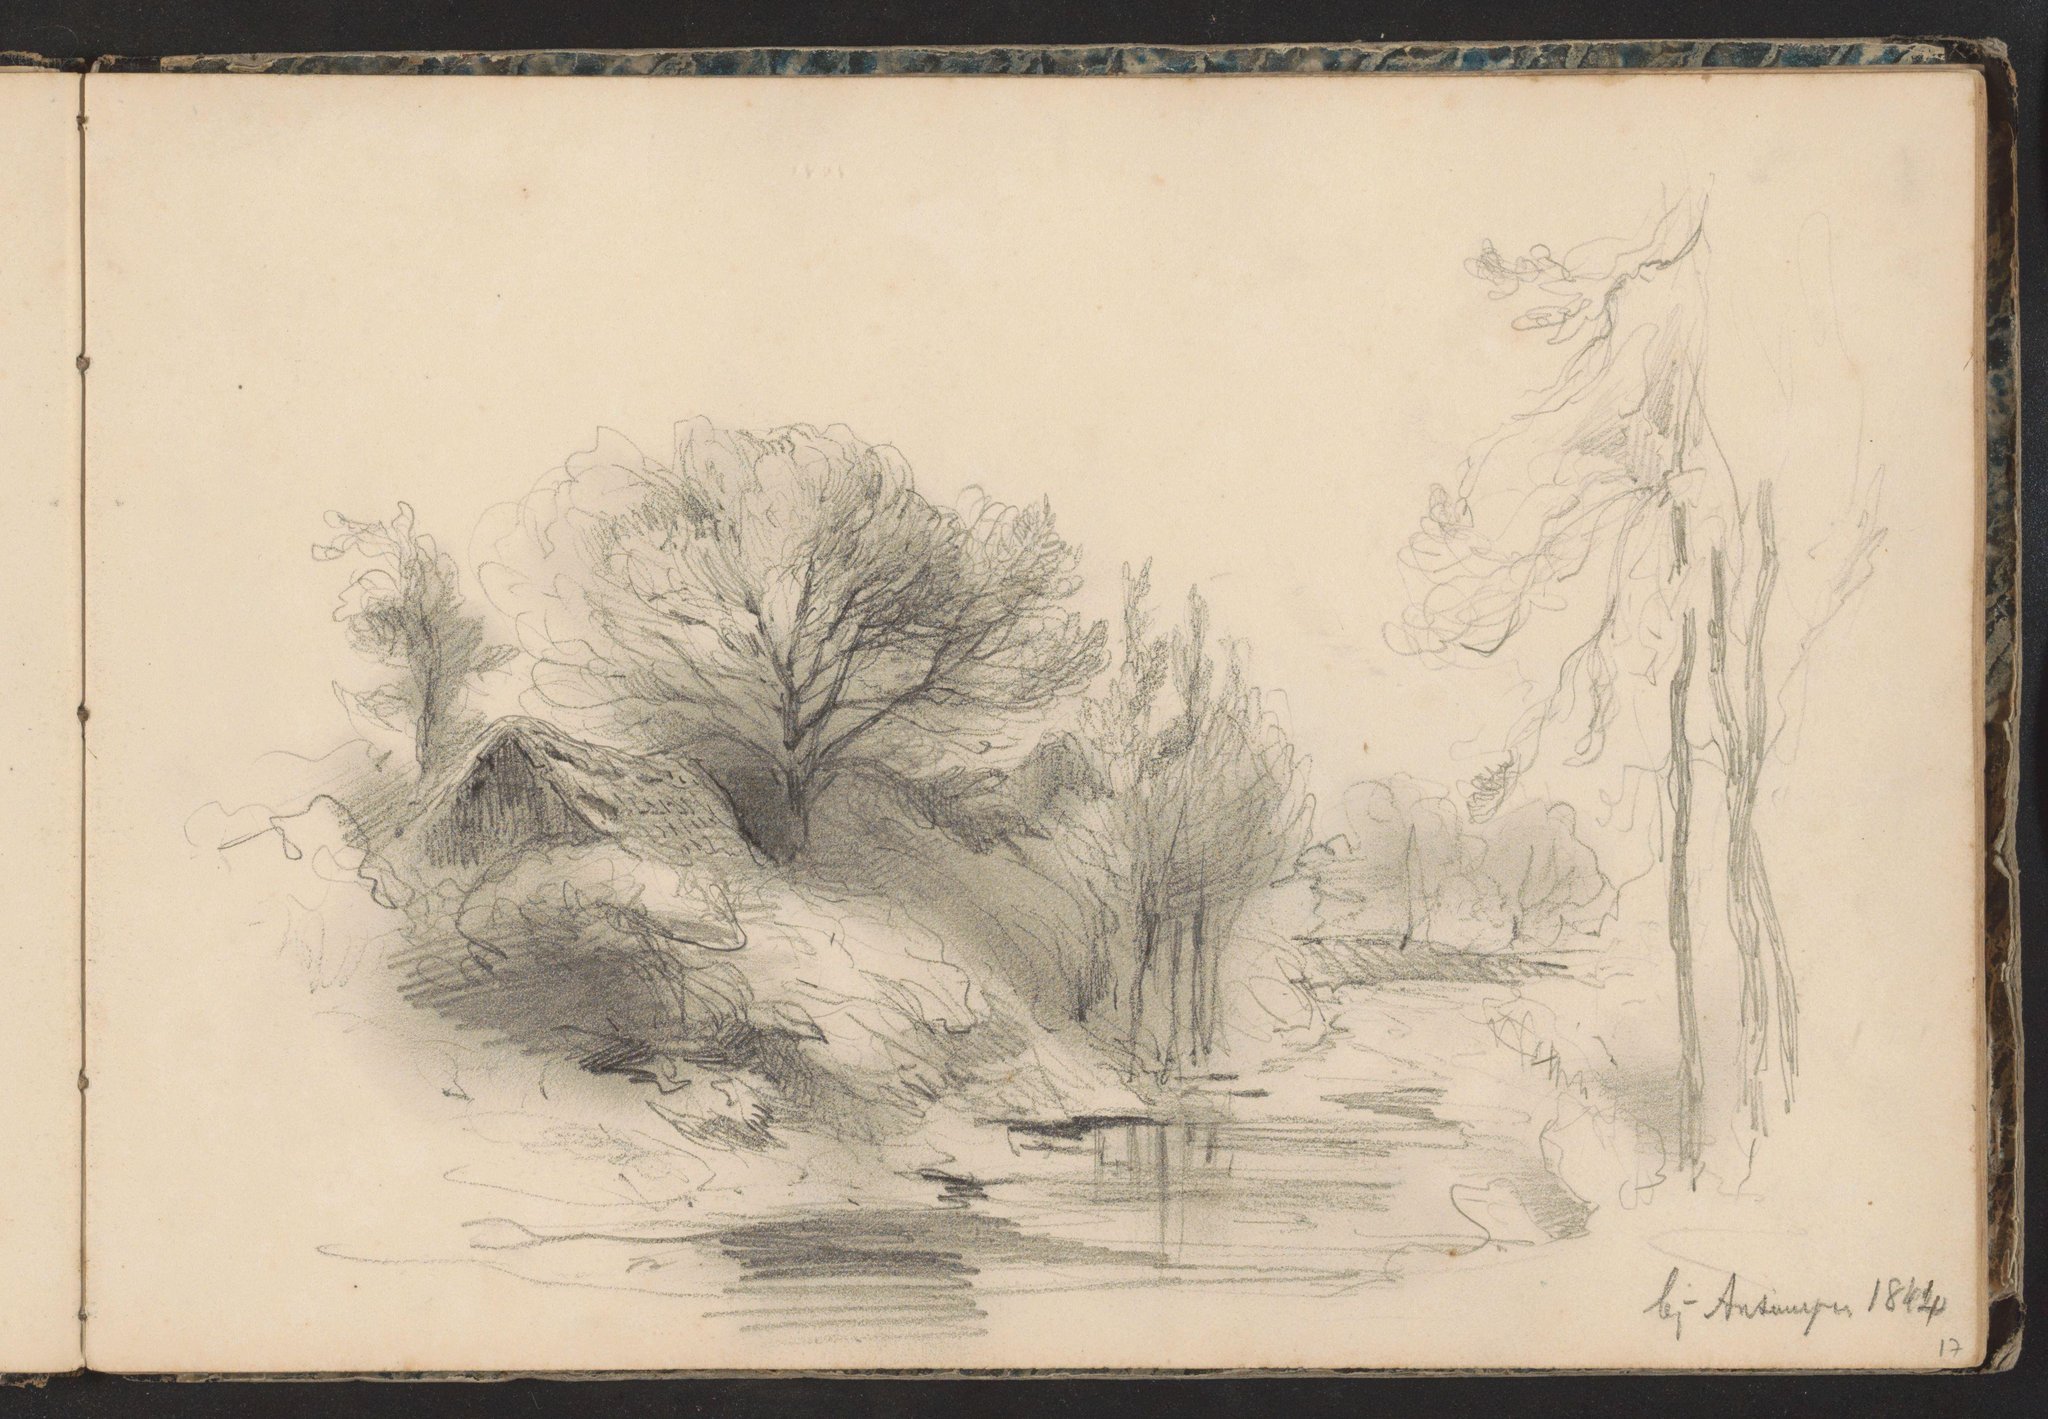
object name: sketchbook leaf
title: Landschap met een rivier bij Antwerpen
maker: johannes tavenraat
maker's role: draughtsman, painter, print maker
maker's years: 1809-1881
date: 1844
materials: paper, pencil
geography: antwerp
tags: river, landscapes with waters, waterscapes, seascapes (in the temperate zone), antwerp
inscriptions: date and inscription: ‘bij Antwerpen 1844.’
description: Blad 17 recto uit een schetsboek met 44 bladen.